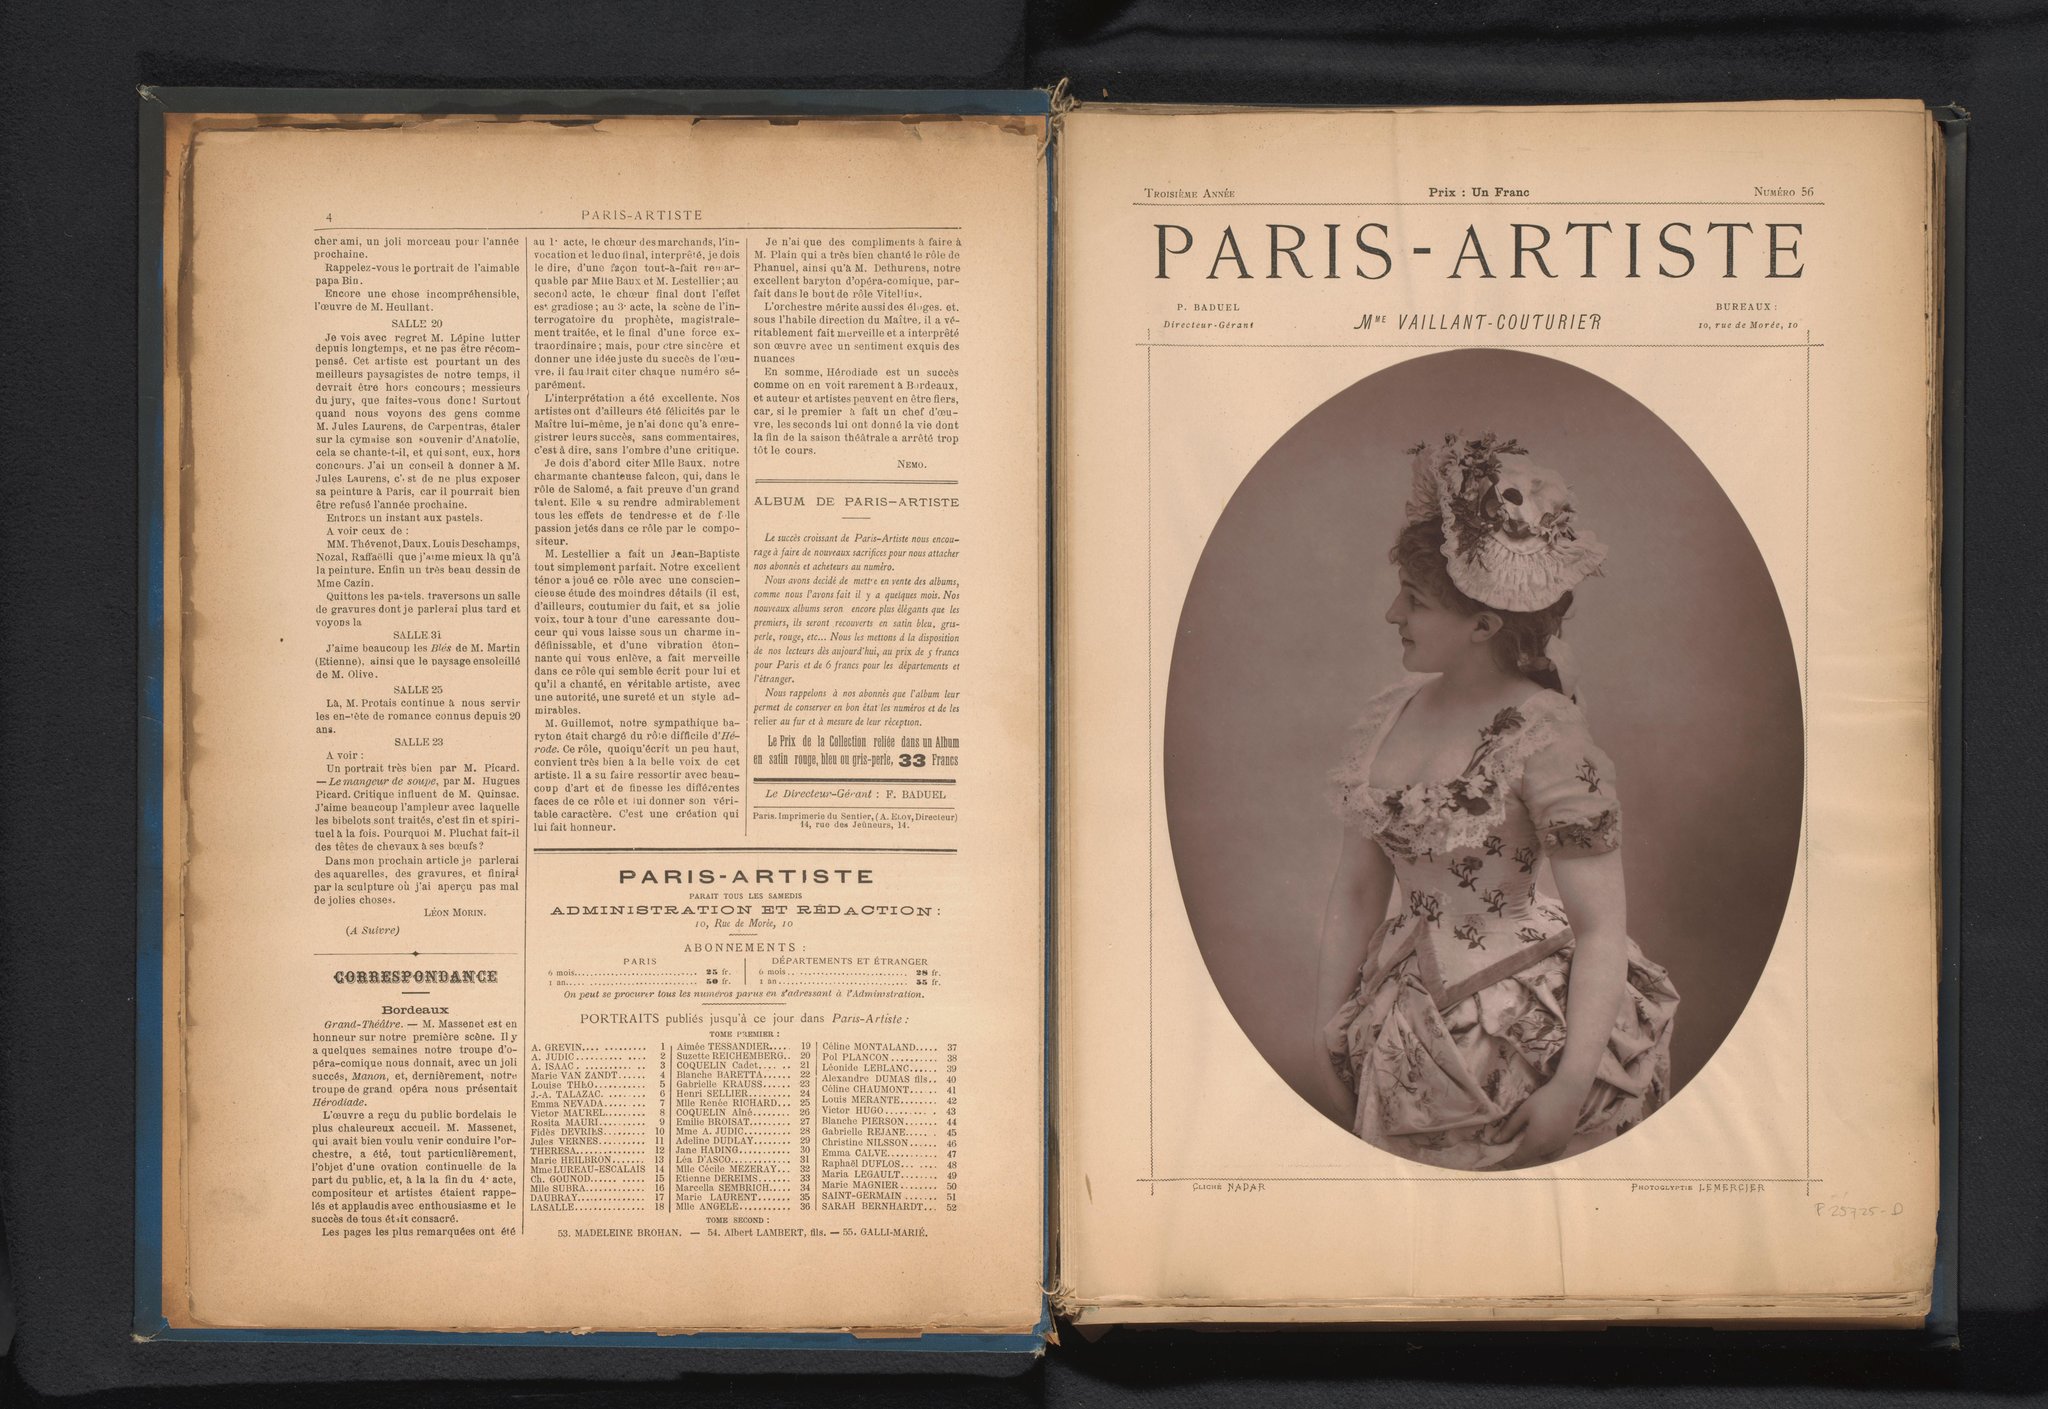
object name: photomechanical print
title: Portret van Vaillant-Couturier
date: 1880-1885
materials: paper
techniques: woodburytype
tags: paris, historical persons - bb - woman, opera-singer (female)